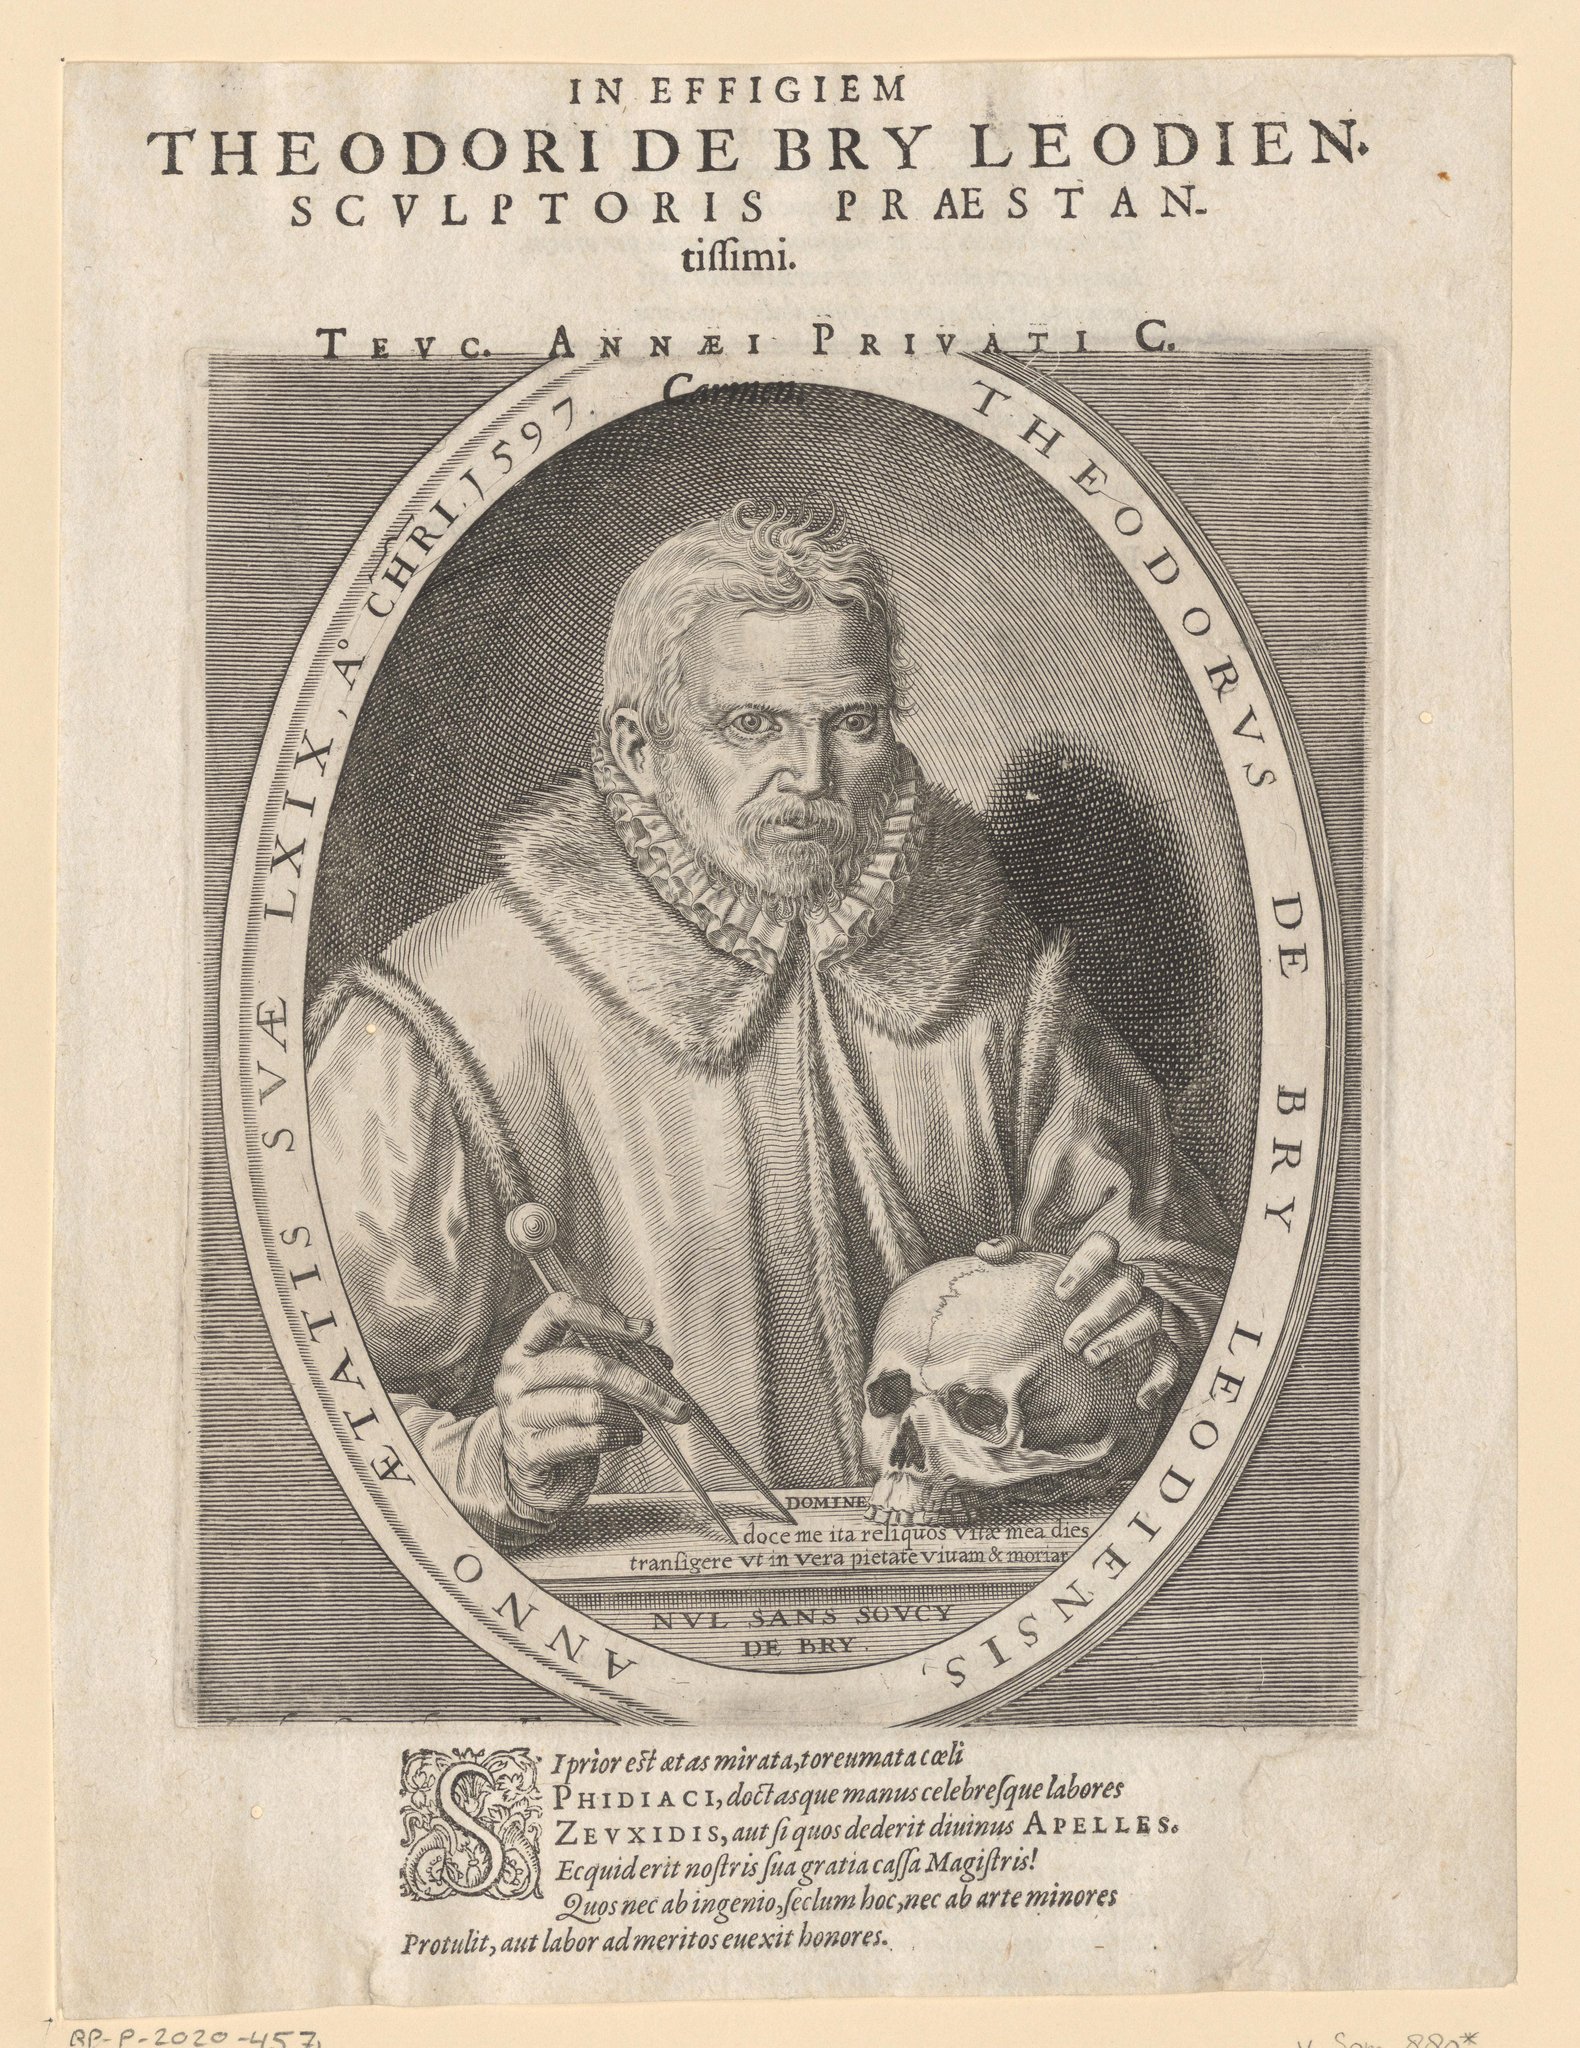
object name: print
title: Zelfportret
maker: theodor de bry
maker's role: draughtsman, print maker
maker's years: 1528-1598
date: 1597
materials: paper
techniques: engraving, letterpress printing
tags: liège, print maker, draughtsman, theodor de bry, historical persons, compasses, portrait, self-portrait of graphic artist, death's head, skull (symbol of death)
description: Prent uit: Boissard, Jean-Jacques. Antiquitatum seu inscriptionum & epitaphiorum (...). Frankfurt an Main: s.n., 1597.